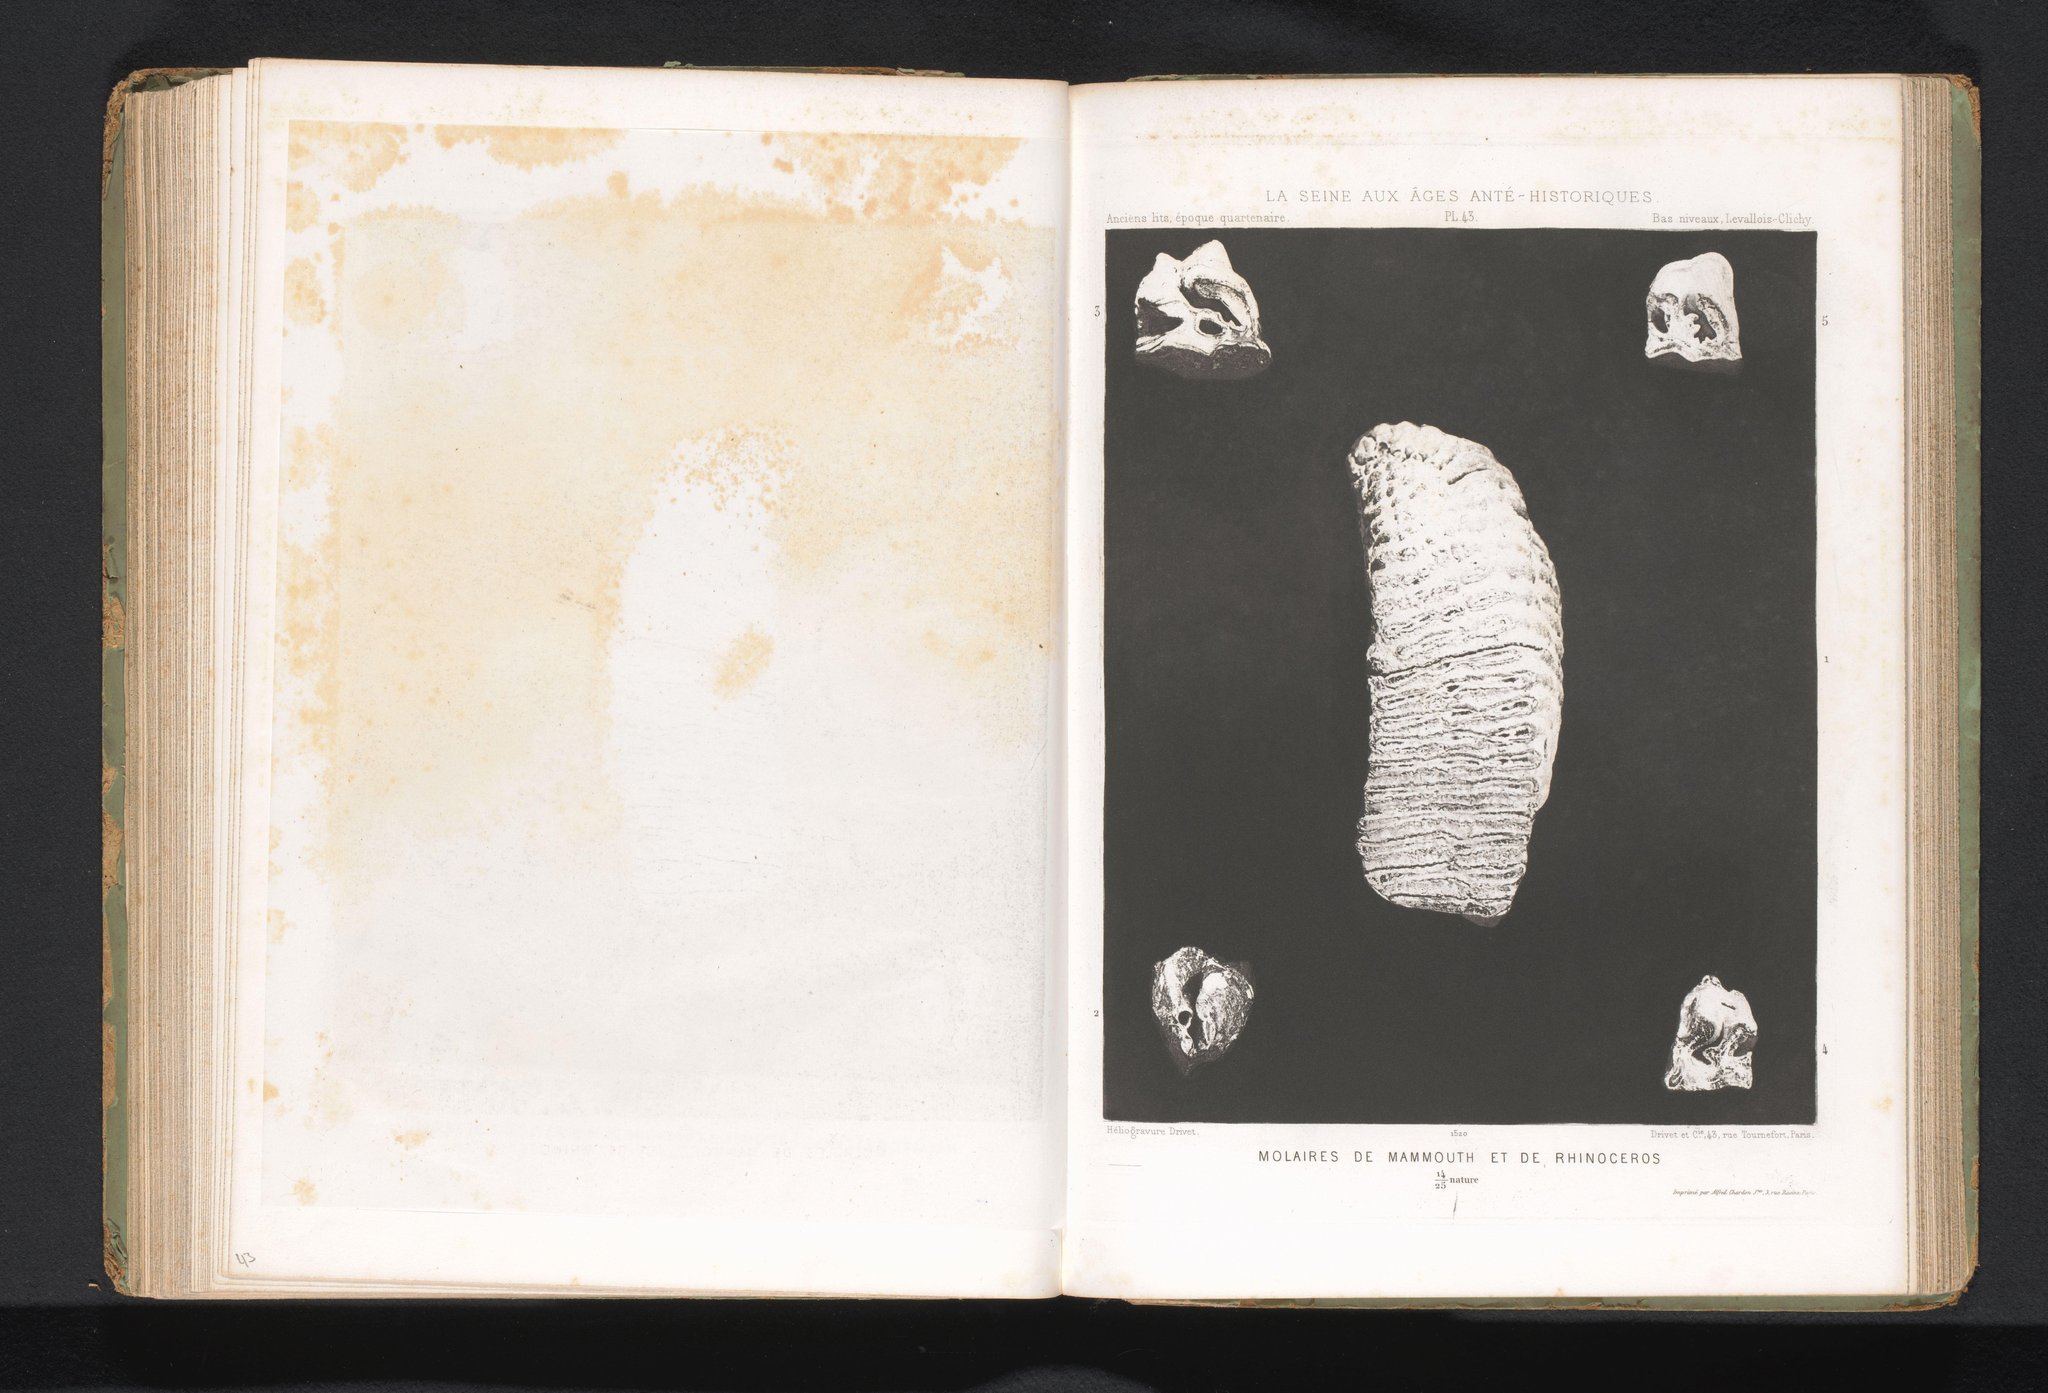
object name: page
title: Vijf kiezen van een mammoet en een neushoorn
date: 1864-1869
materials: paper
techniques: photoaquatint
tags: mammals (+ skeleton of an animal), palaeontology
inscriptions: inscription: ‘1520’, inscription: ‘14/25 nature’